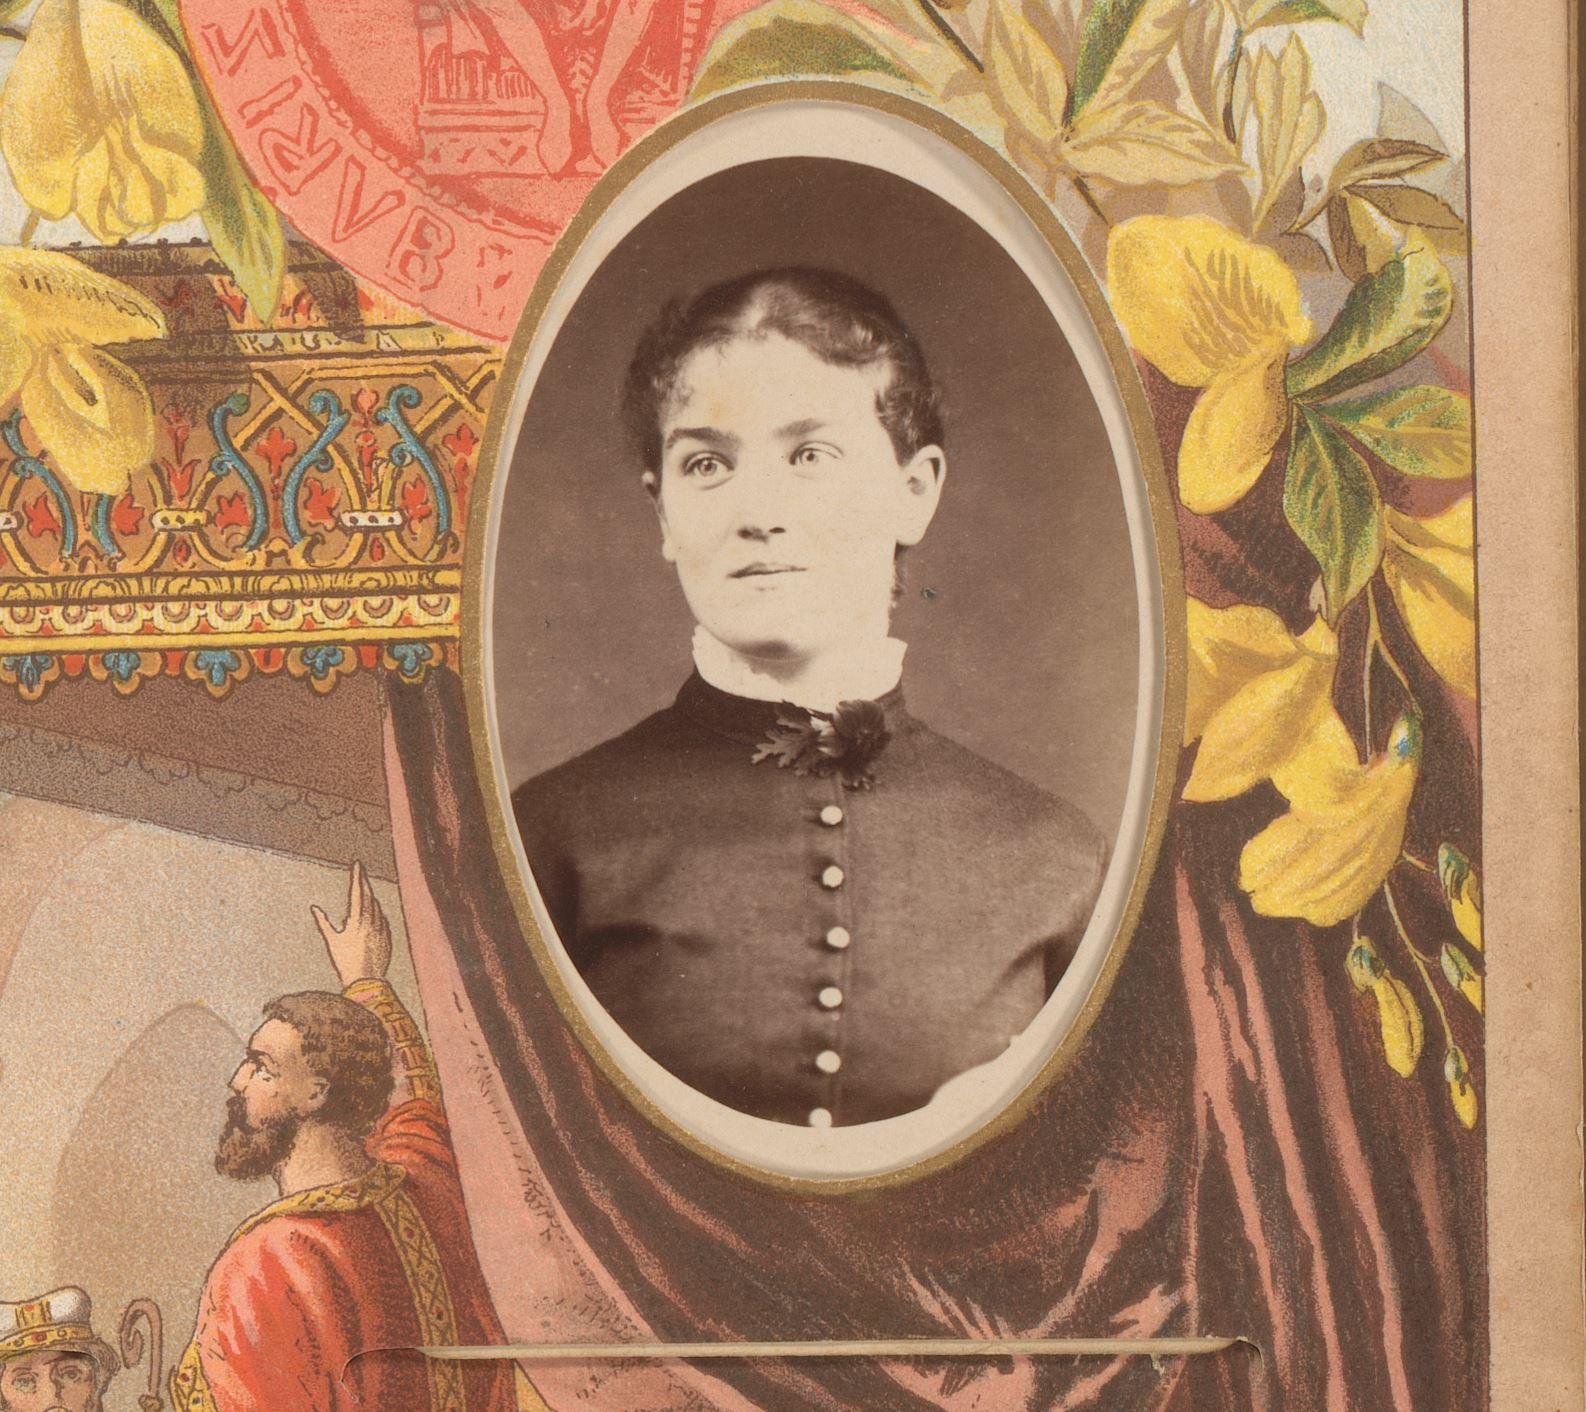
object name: album leaf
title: Portret van een vrouw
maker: Anonymous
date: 1883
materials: cardboard, photographic support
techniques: albumen print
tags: historical persons - bb - woman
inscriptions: dedication: ‘With kindest love/ [to] my dear old/ friend/ [...]/ 1883’